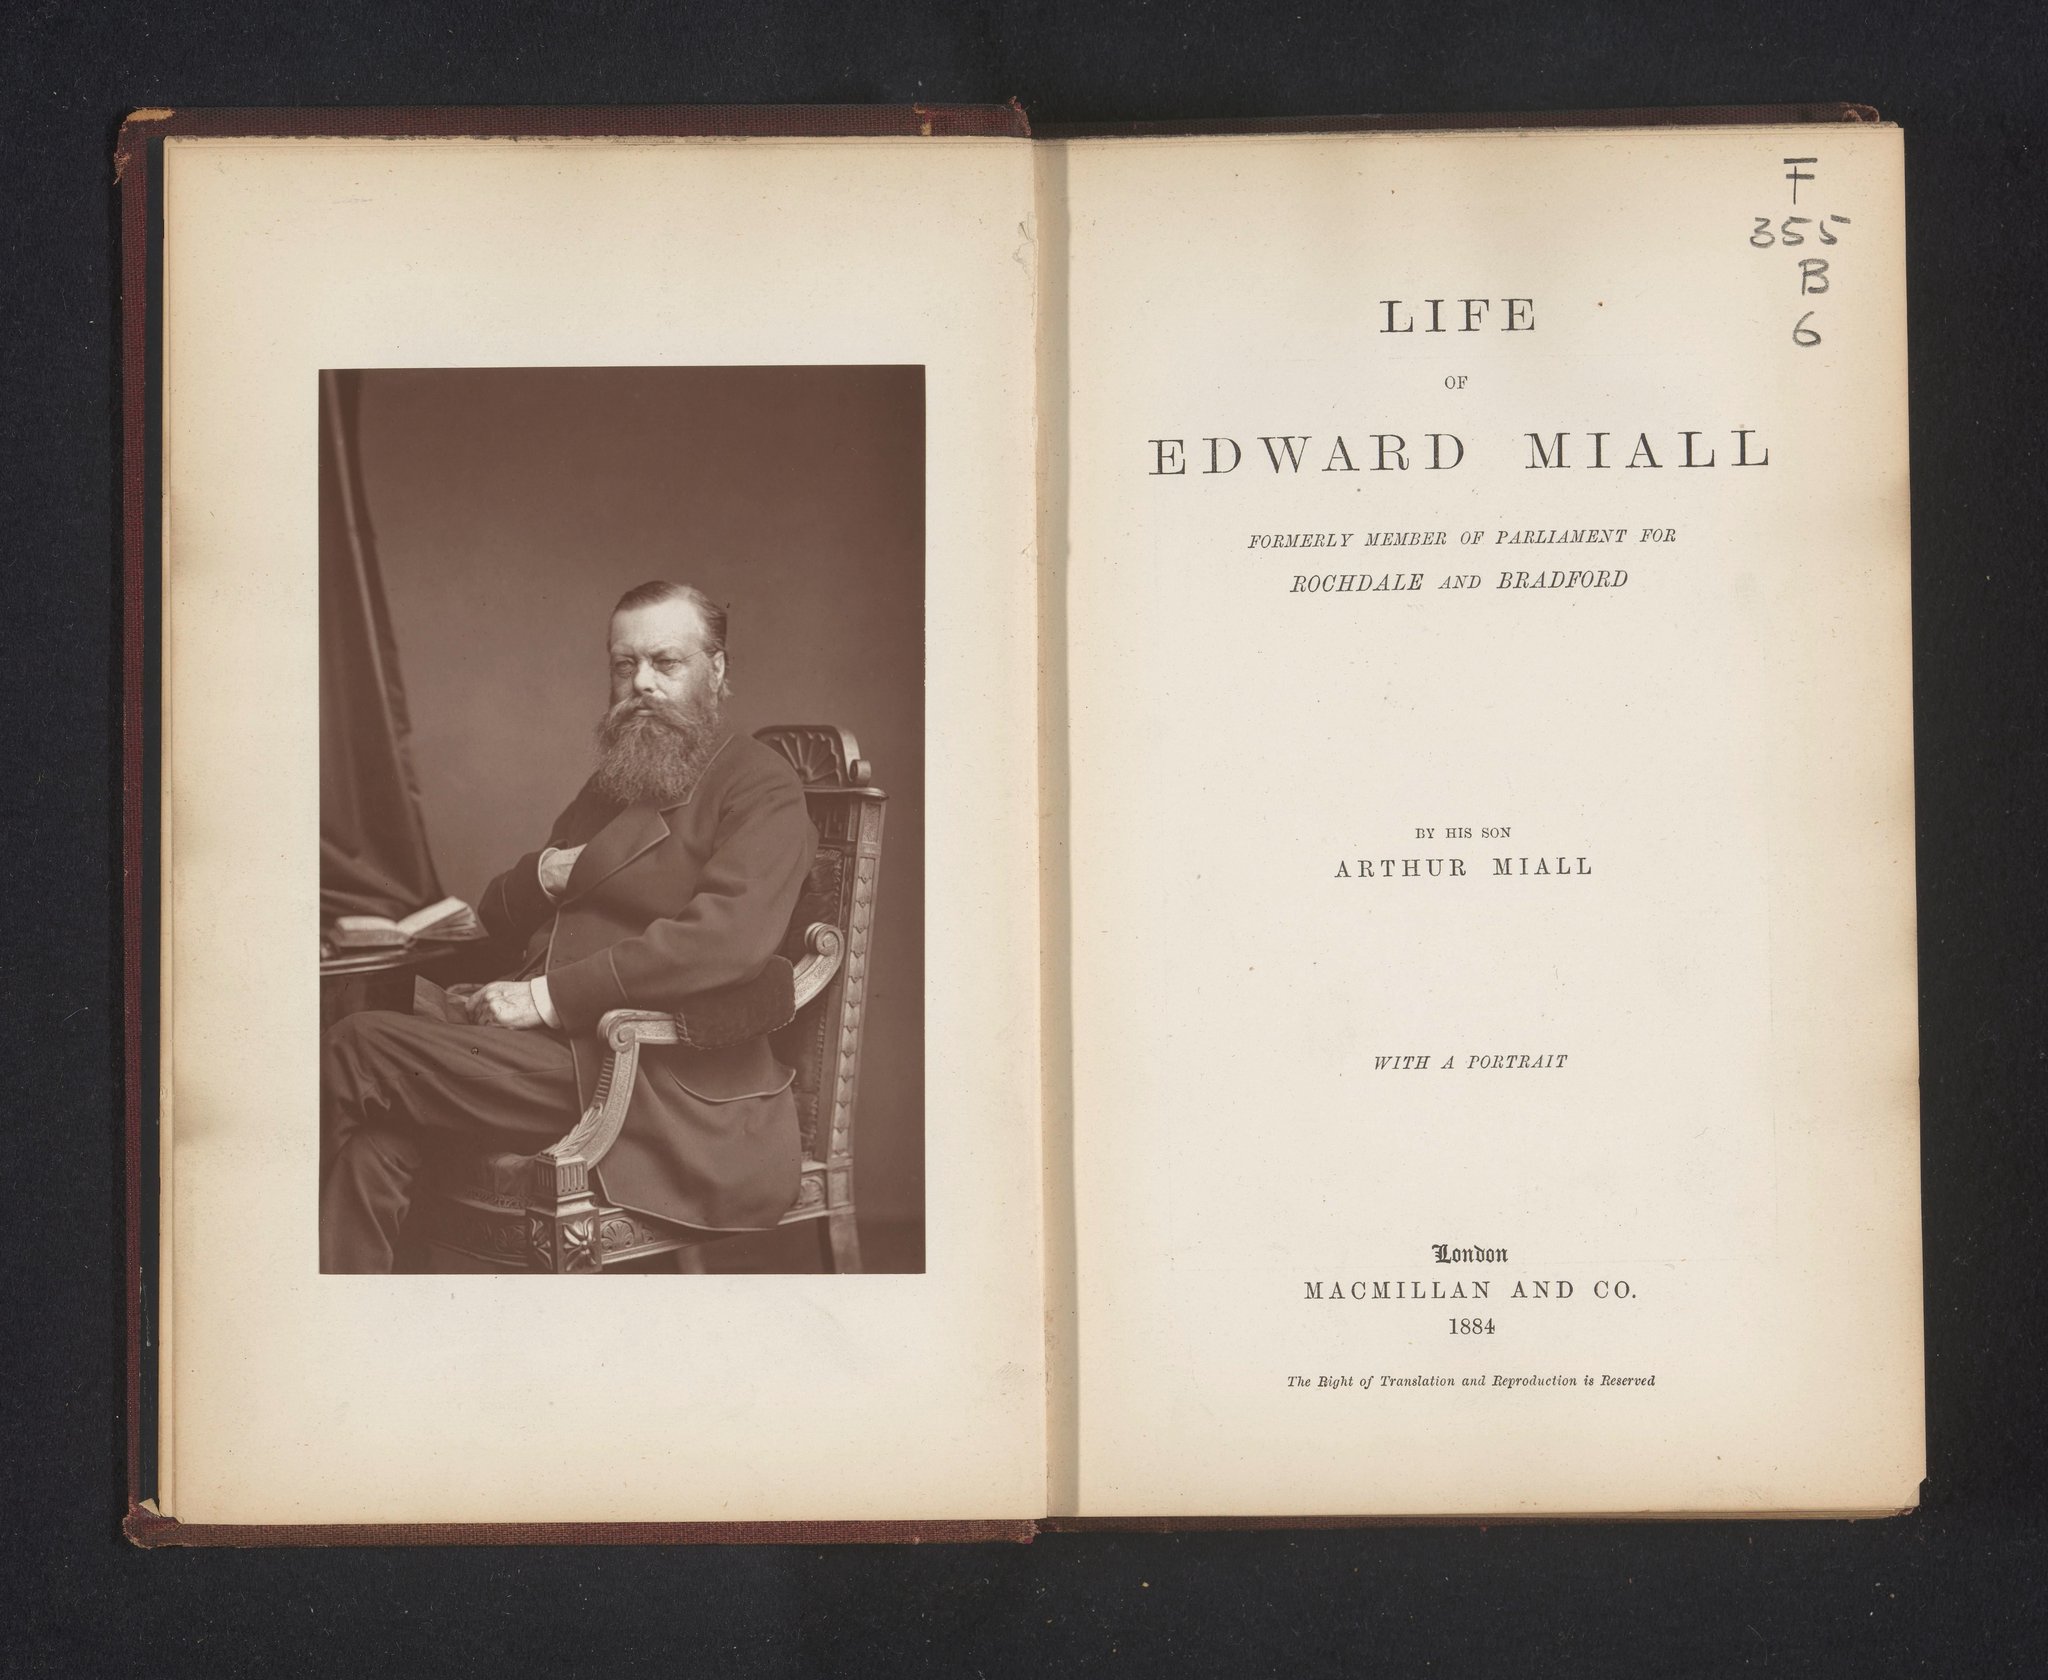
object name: photomechanical print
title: Portret van Edward Miall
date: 1869-1879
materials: paper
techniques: woodburytype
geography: birmingham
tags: journalist, reporter